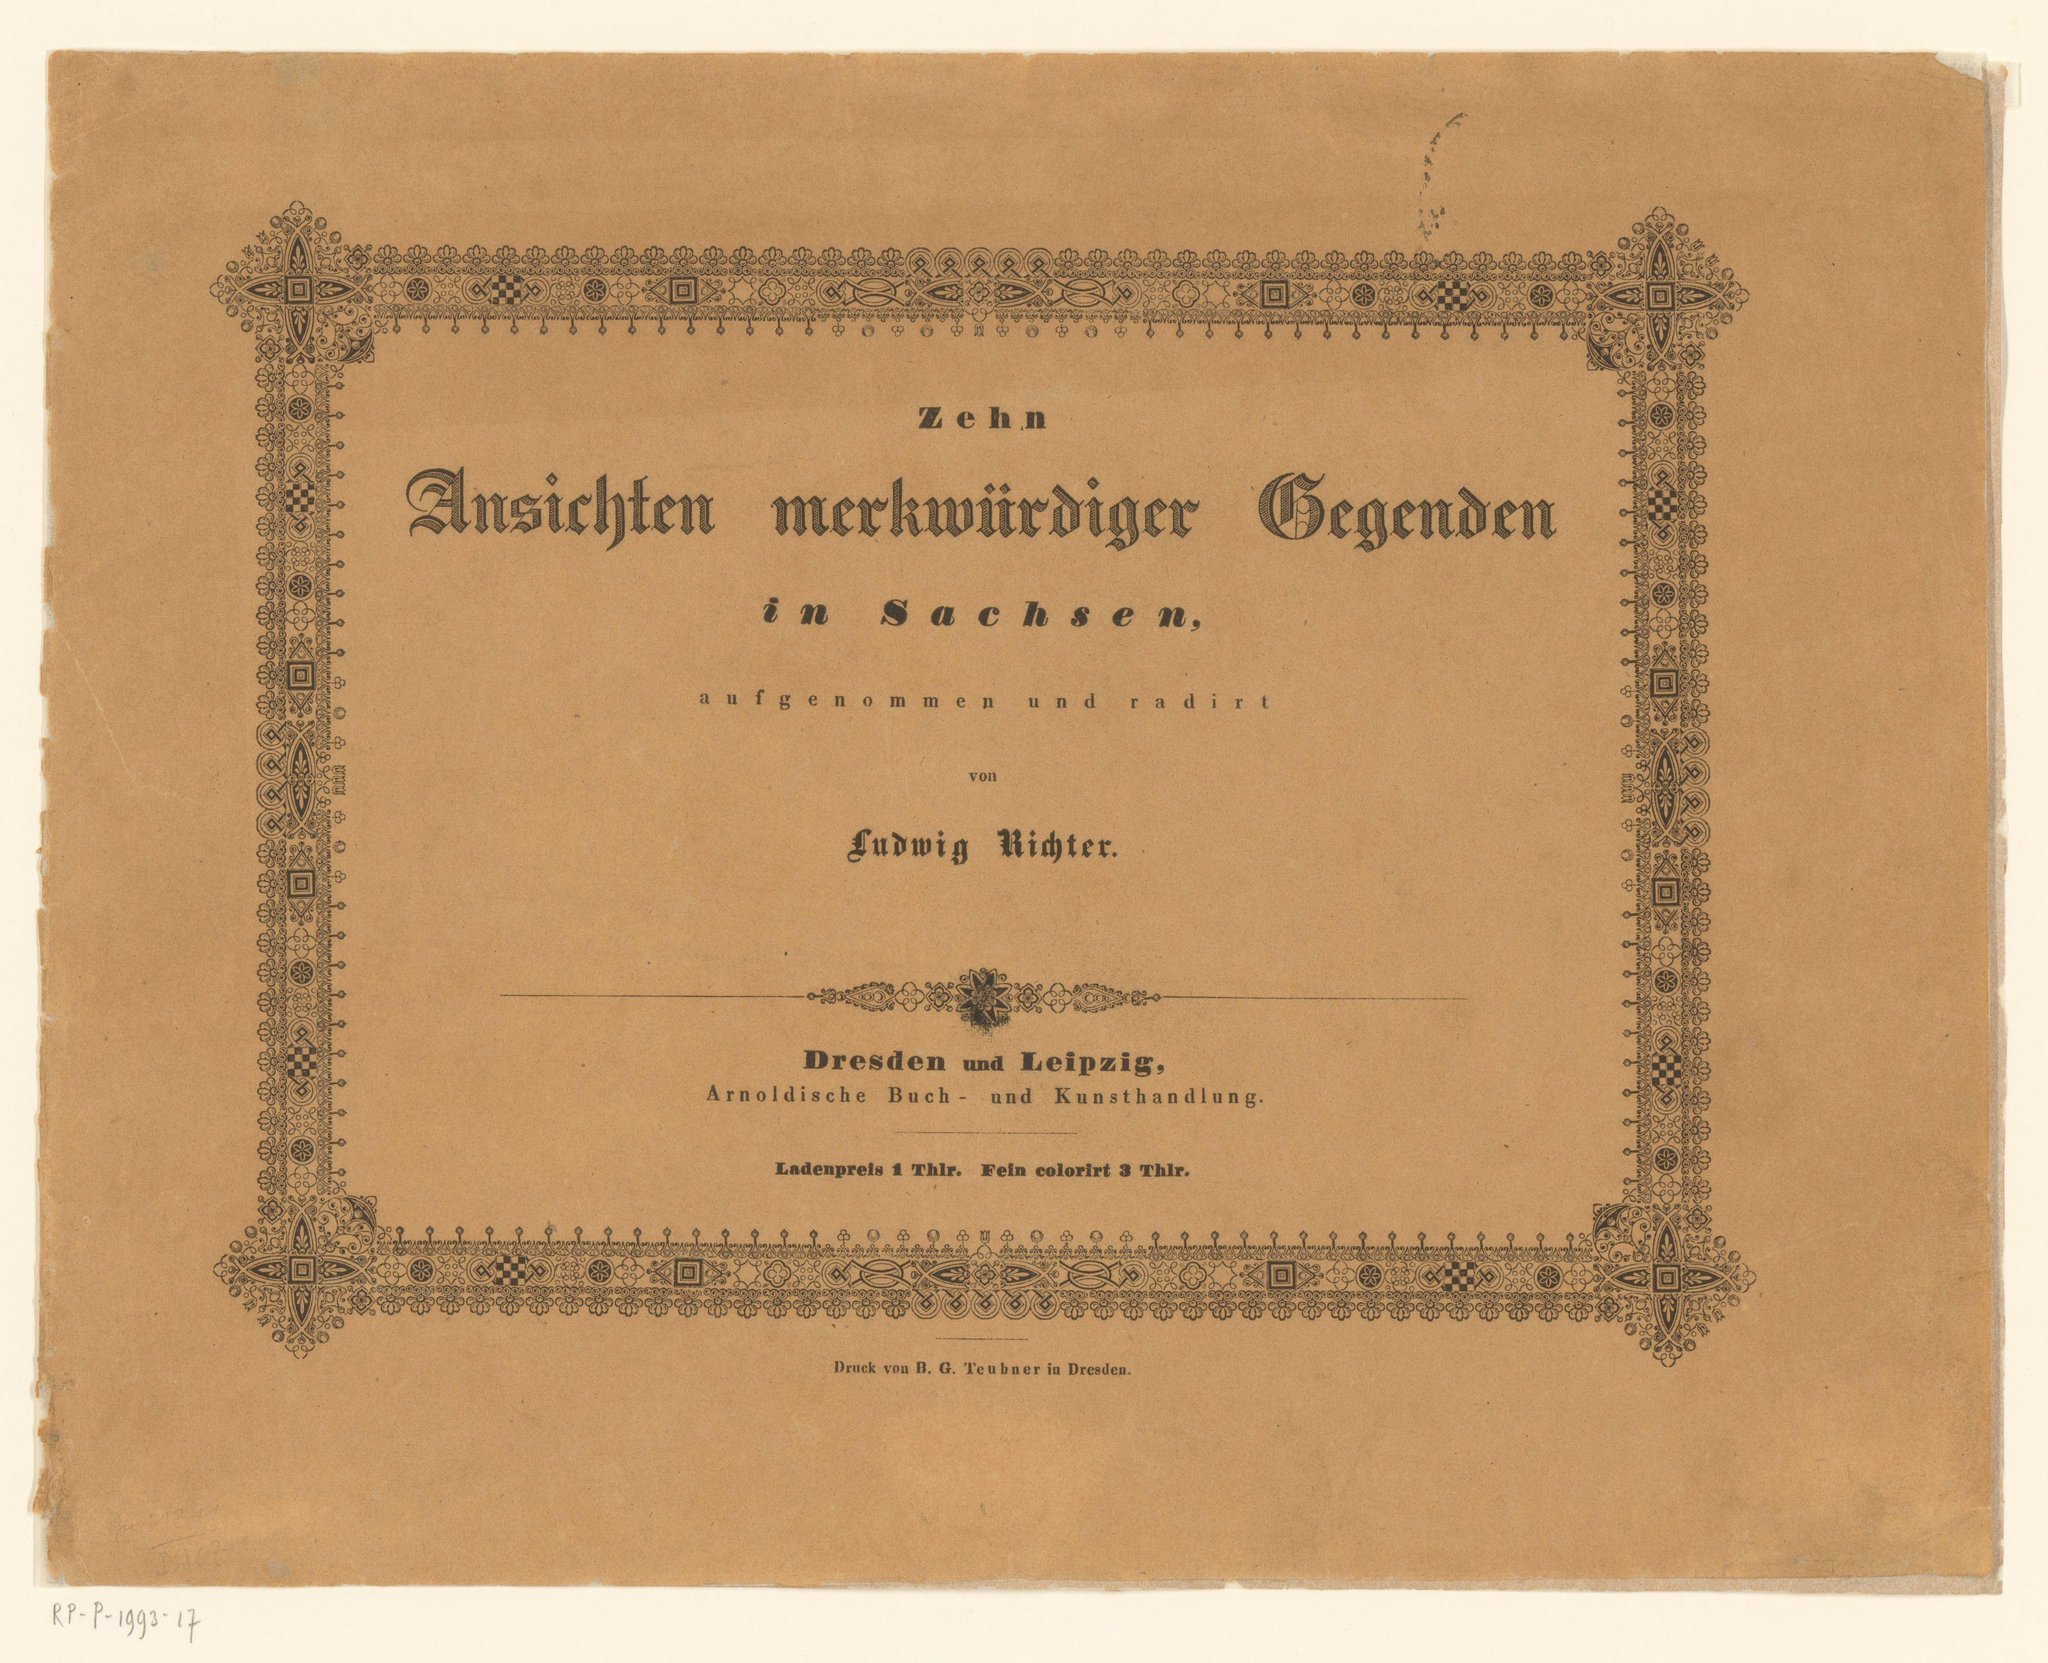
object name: print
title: Zehn Ansichten merkwürdiger Gegenden in Sachsen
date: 1828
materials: paper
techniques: engraving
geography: leipzig